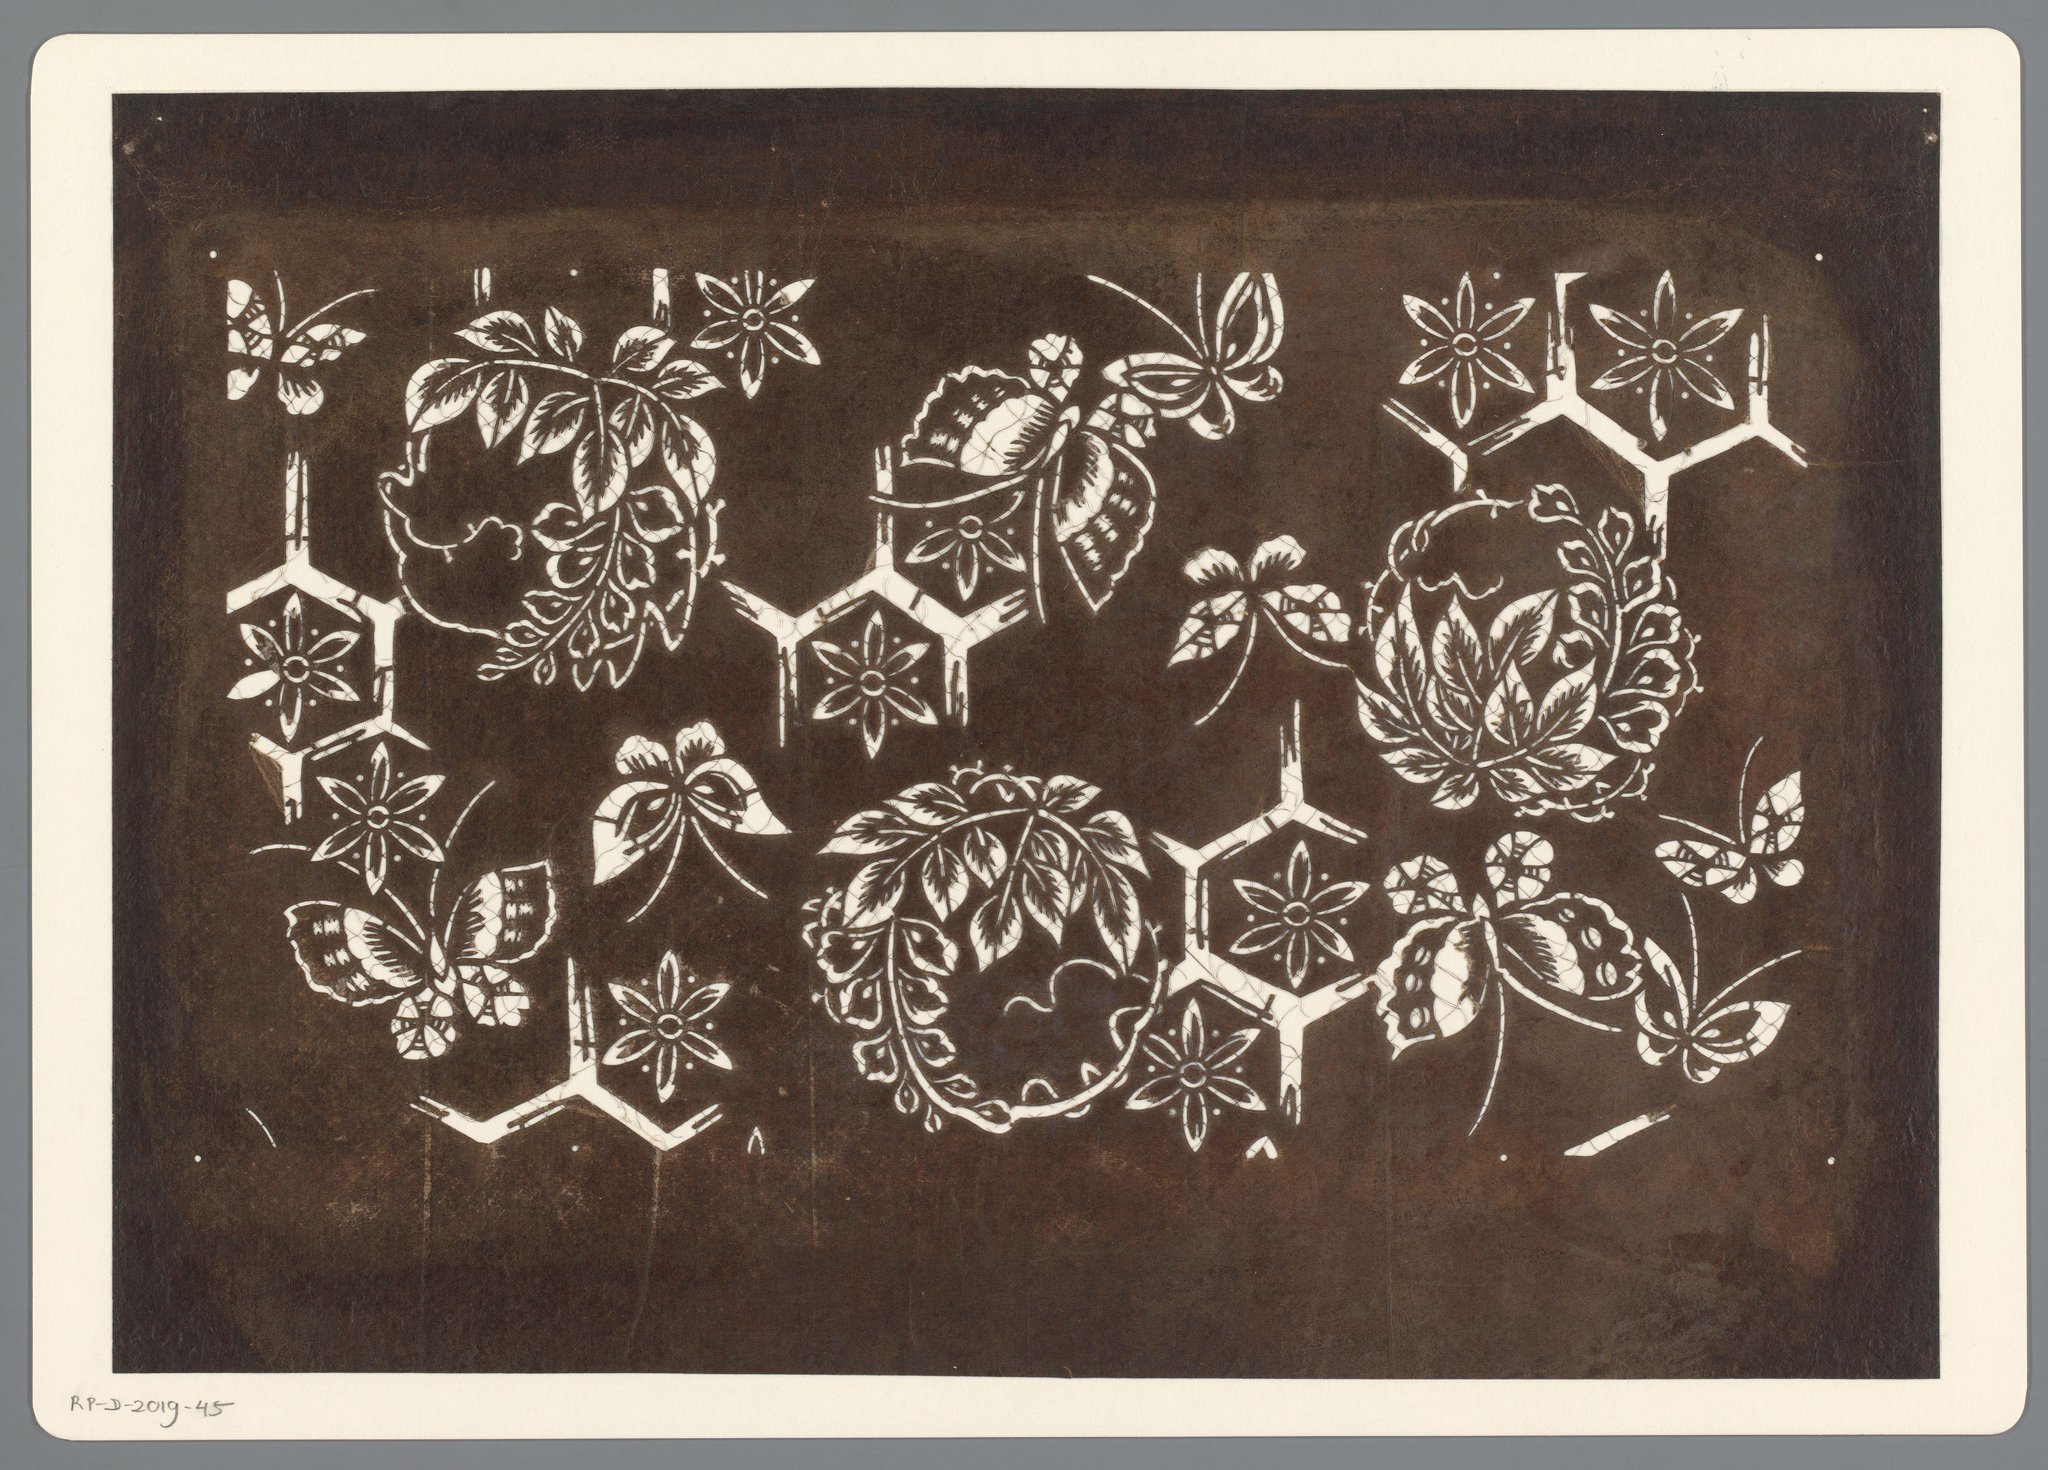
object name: katagami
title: Sjabloon met vlinders en blauweregen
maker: Anonymous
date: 1800-1909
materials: paper, silk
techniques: cutting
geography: japan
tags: ornament derived from animal forms, plants and herbs: wisteria, insects: butterfly, ornament derived from plant forms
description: Japanse sjabloon (katagami) met een patroon van vlinders tussen blauweregen (Wisteria) en zeshoekige elementen.